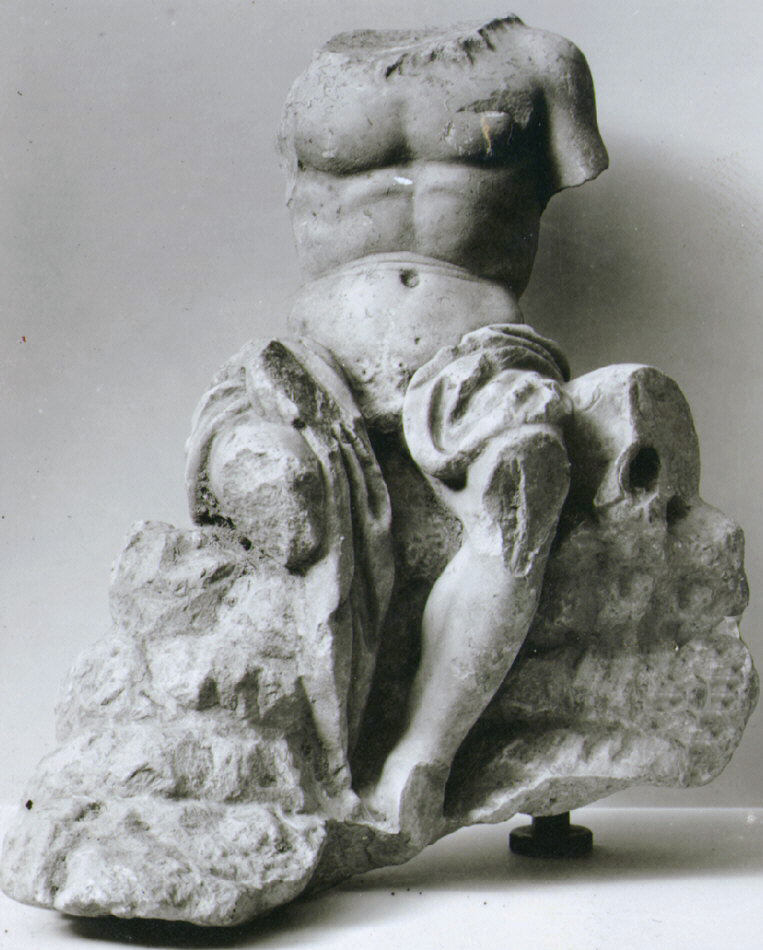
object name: statuette of a man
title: Marble statuette of a seated man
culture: roman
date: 1-200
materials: marble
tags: men